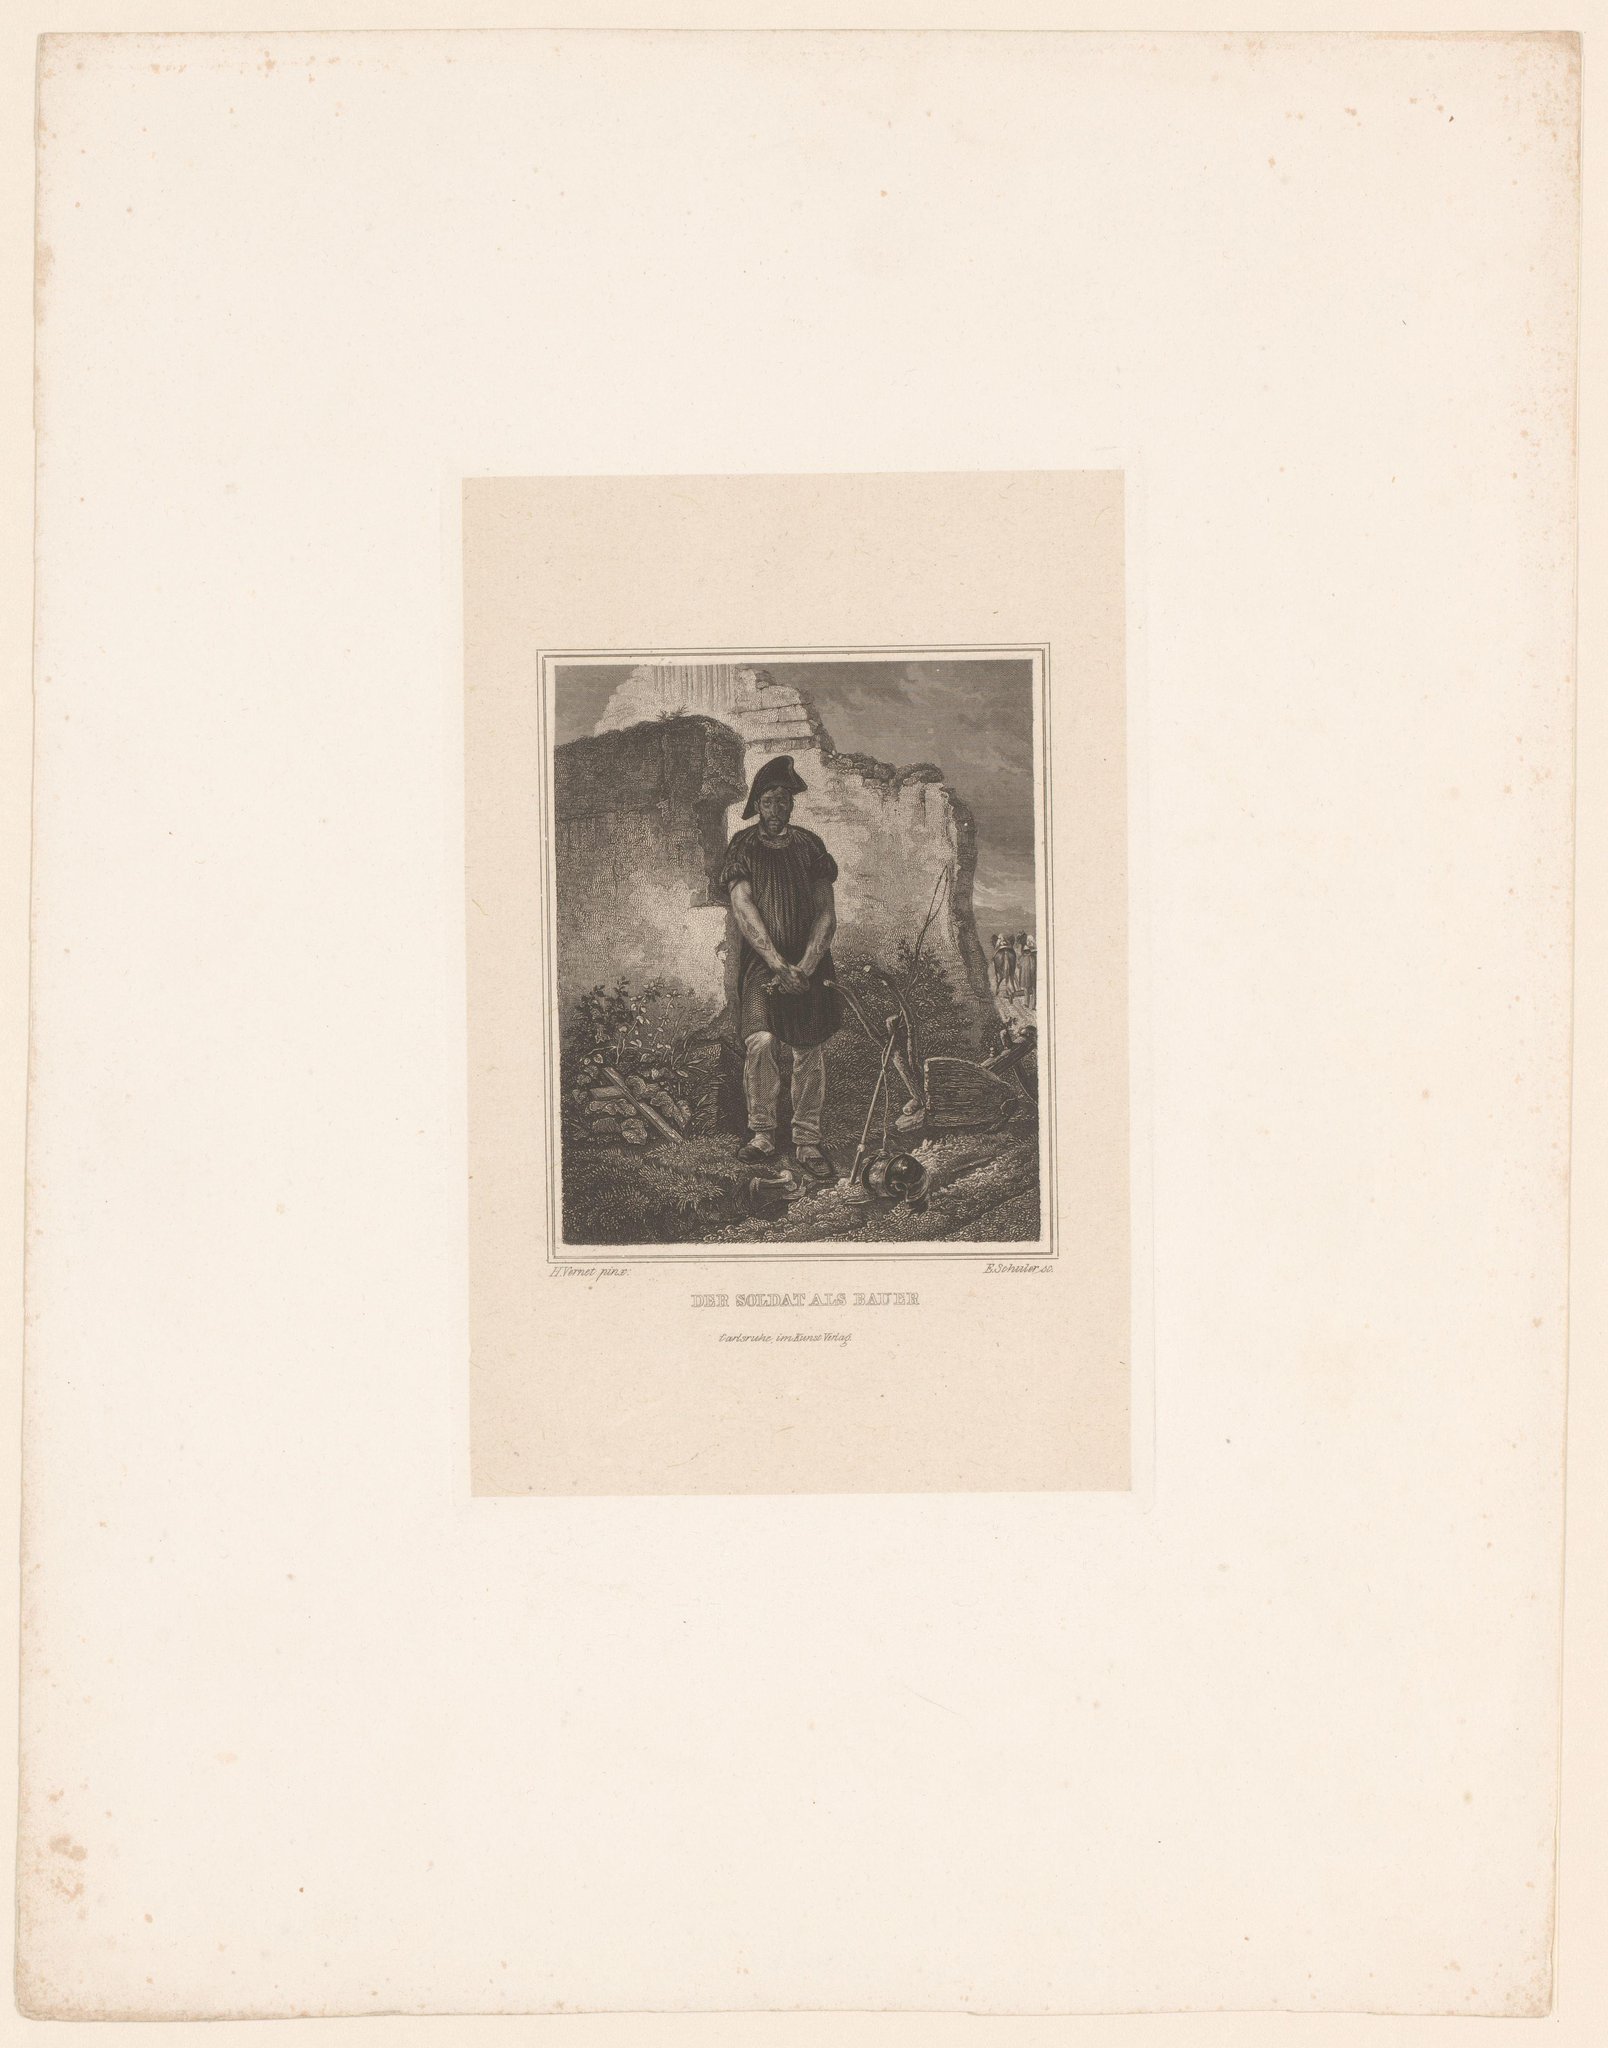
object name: print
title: Soldaat als boer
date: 1816-1882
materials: paper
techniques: engraving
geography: karlsruhe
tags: farmers, the soldier; the soldier's life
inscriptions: collector's mark: Lugt 2228